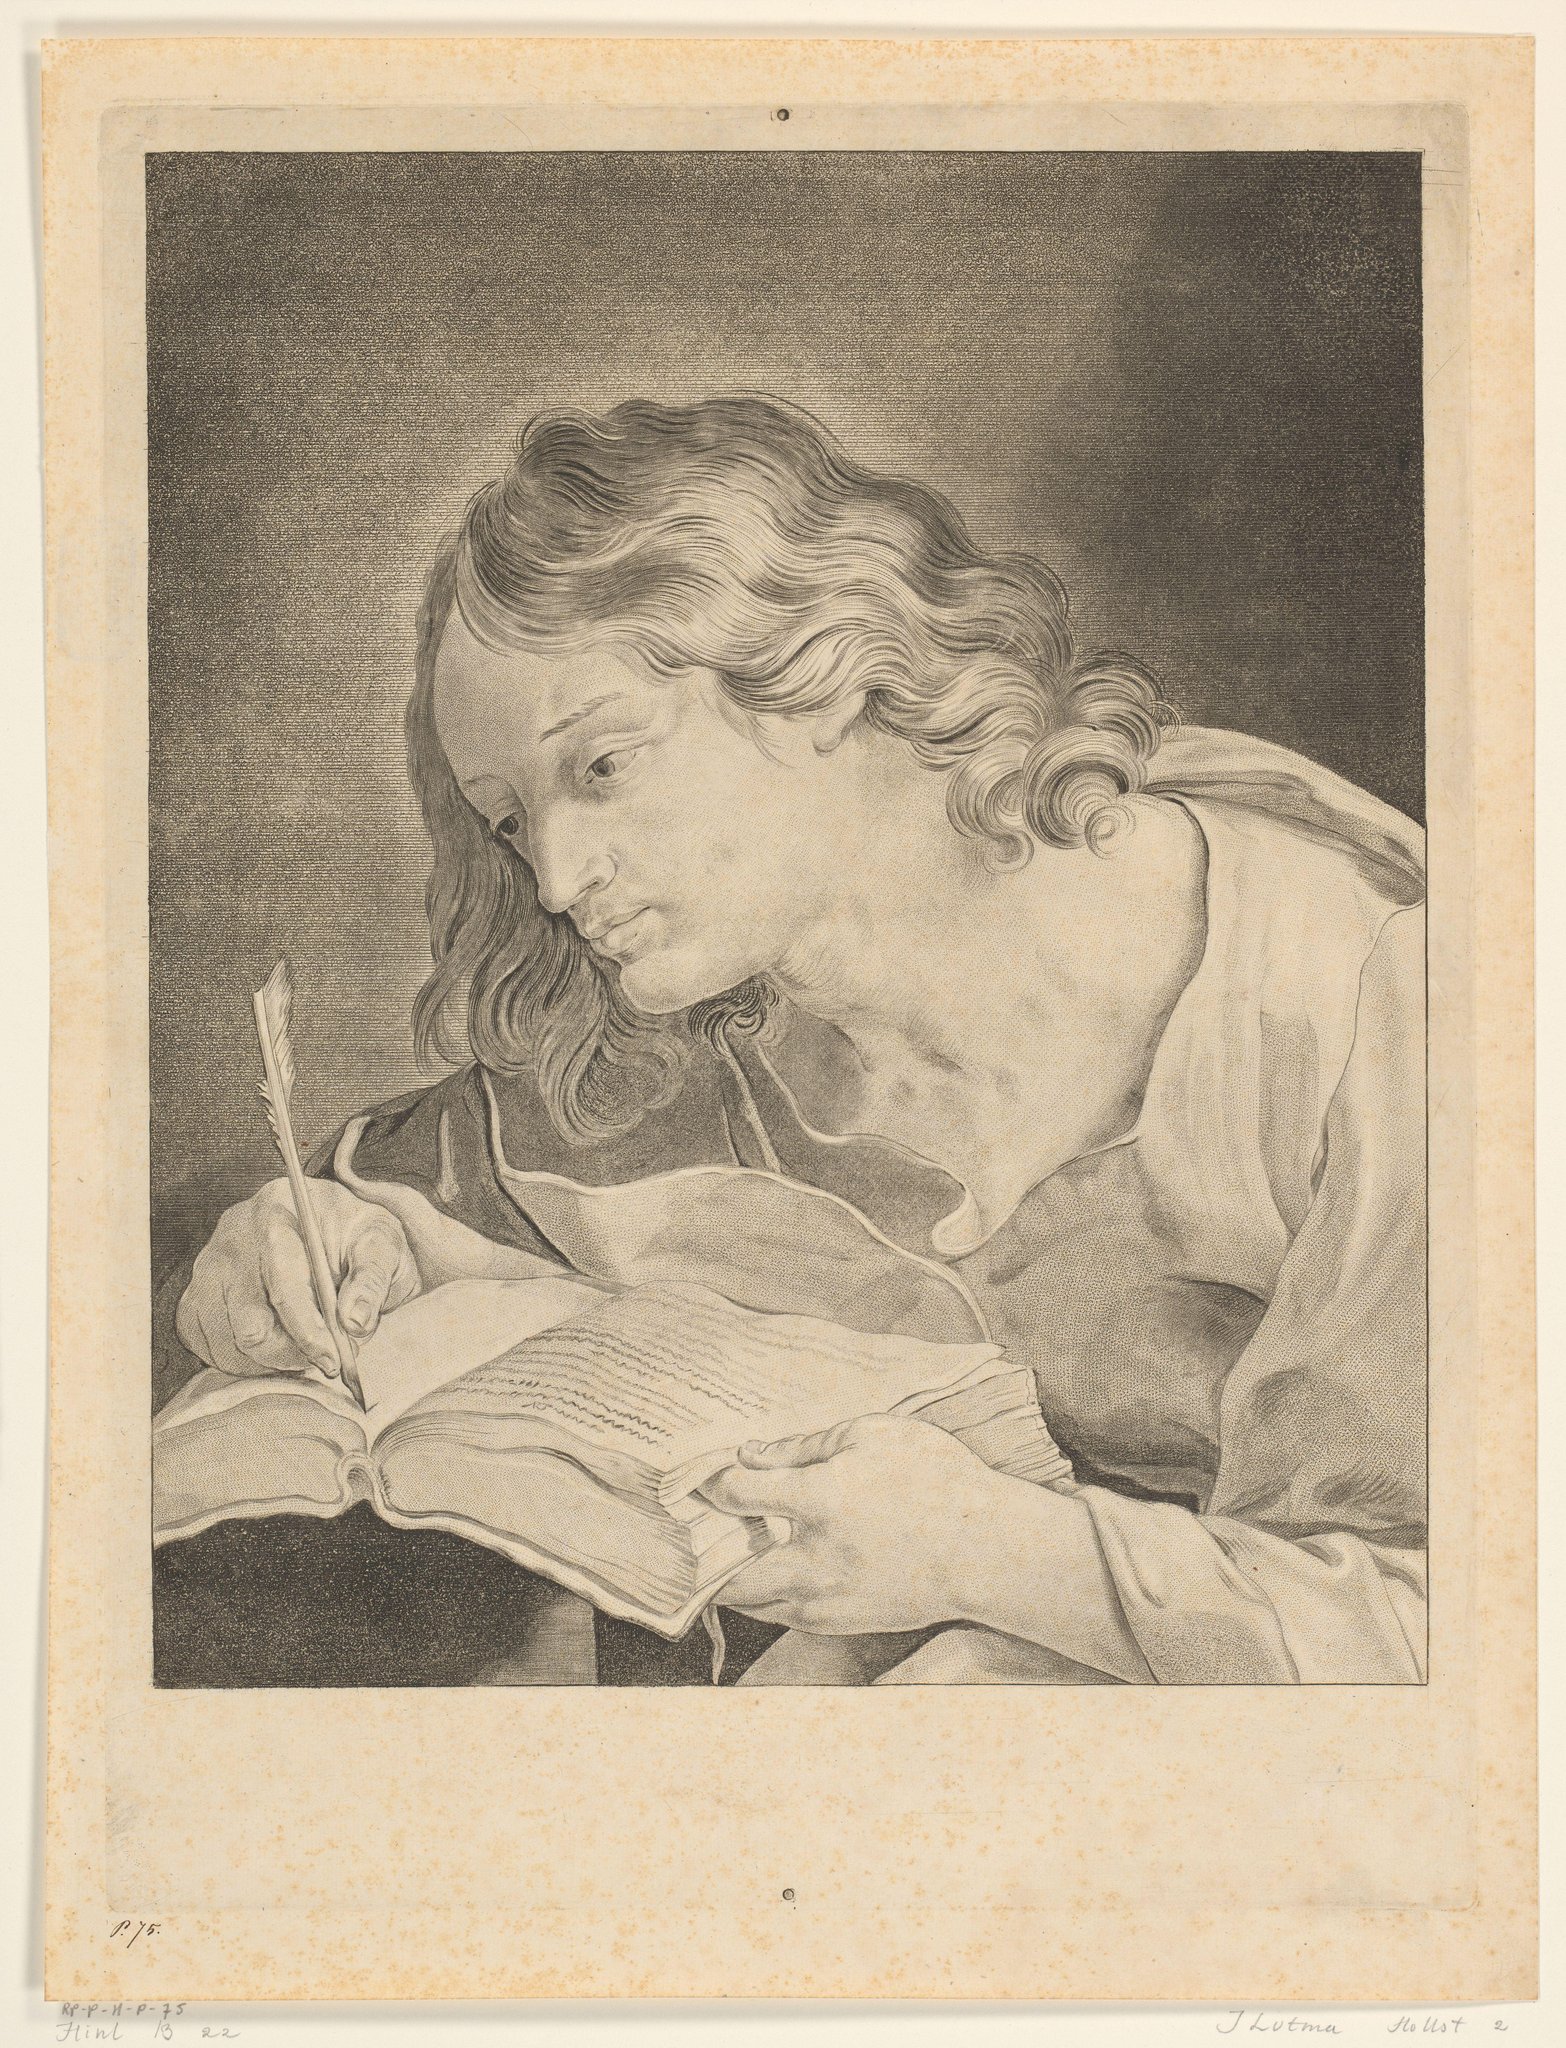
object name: print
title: Johannes de Evangelist, schrijvend in een boek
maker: johannes lutma (1624-1689)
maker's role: print maker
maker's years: 1624-1689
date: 1646-1658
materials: paper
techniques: engraving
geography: amsterdam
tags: the apostle john the evangelist; possible attributes: book, cauldron, chalice with snake, eagle, palm, scroll, st. john the evangelist writing the gospel, usually the eagle present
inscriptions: collector's mark: Lugt 11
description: Deze prent maakte ten minste tot 1979 deel uit van een prentalbum met de titel: 't Cabinet der Italiaense schilderije antique statue en borstbeelde van de heer Renst 145 stucks. Simon Schijnvoet heeft in 1709 aan dit album het Schijnvoet-nummer 22, liber nummer 20 toegekend. Prent uit serie Caelaturae met vierendertig reprodukties naar Italiaanse en Nederlandse schilders, vervaardigd door de allerbeste graveurs in opdracht van de verzamelaar Gerard Reynst.